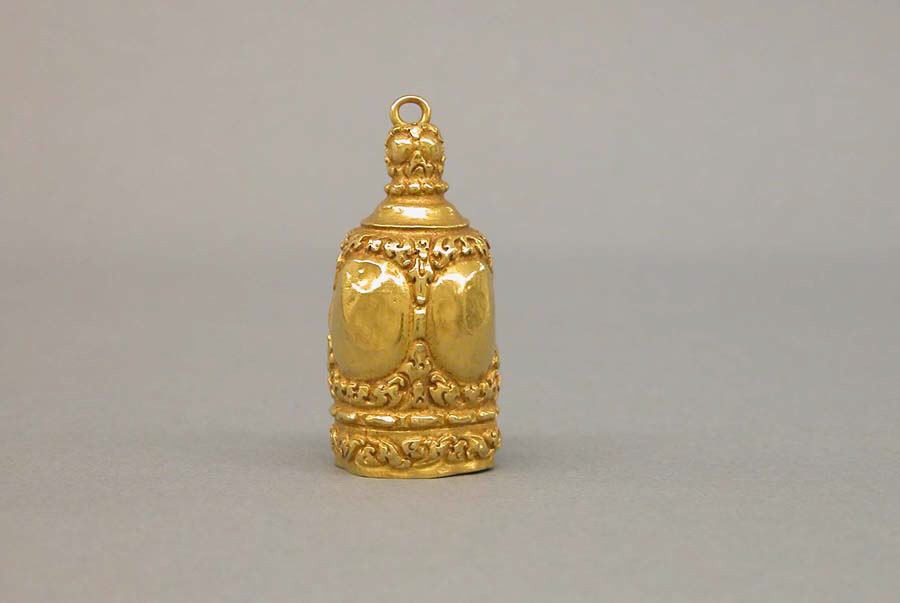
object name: finial cap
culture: indonesian, javanese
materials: gold